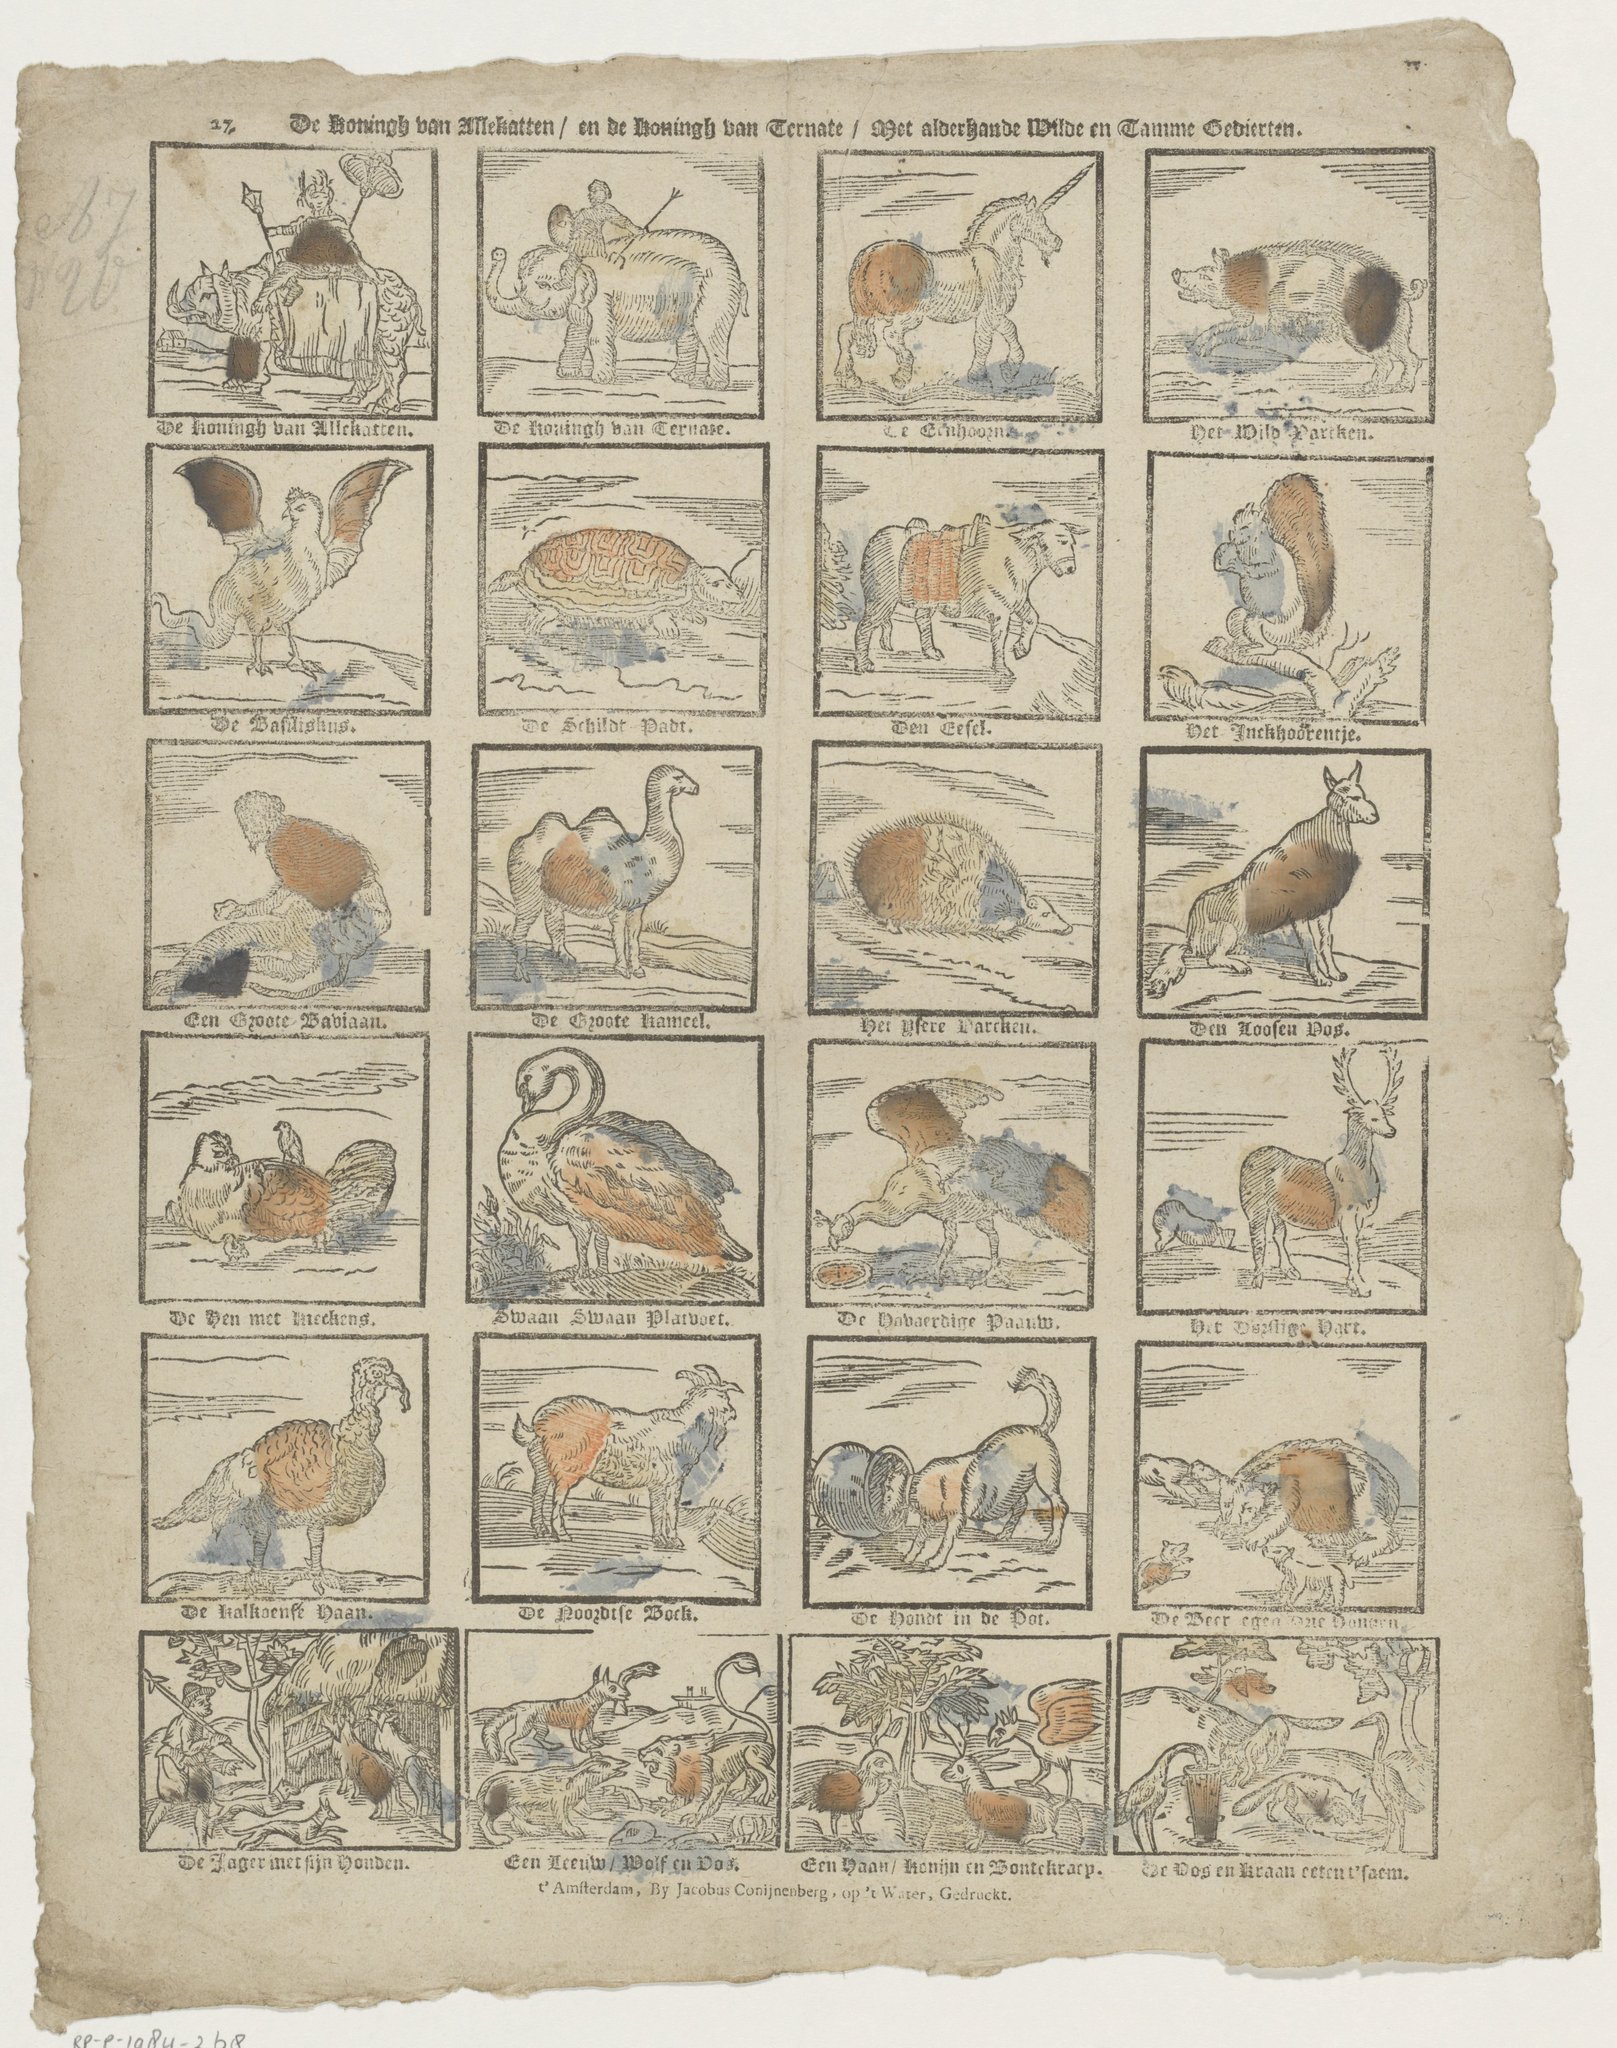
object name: popular print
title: De koningh van Allekatten / en de koningh van Ternate / met alderhande wilde en tamme gedierten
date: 1711-1723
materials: paper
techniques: colour, letterpress printing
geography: netherlands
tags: hoofed animals: camel, unicorn, animals, tortoises, turtles, birds, hoofed animals: rhinoceros, beasts of prey, predatory animals: bear, trunked animals: elephant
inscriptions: collector's mark: Lugt 2760, collector's mark: Lugt 2228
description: Blad met 24 voorstellingen van dieren, zoals een olifant, een schildpad, een zwaan en een beer. Onder elke afbeelding de naam van het afgebeelde dier. Genummerd linksboven: 27.